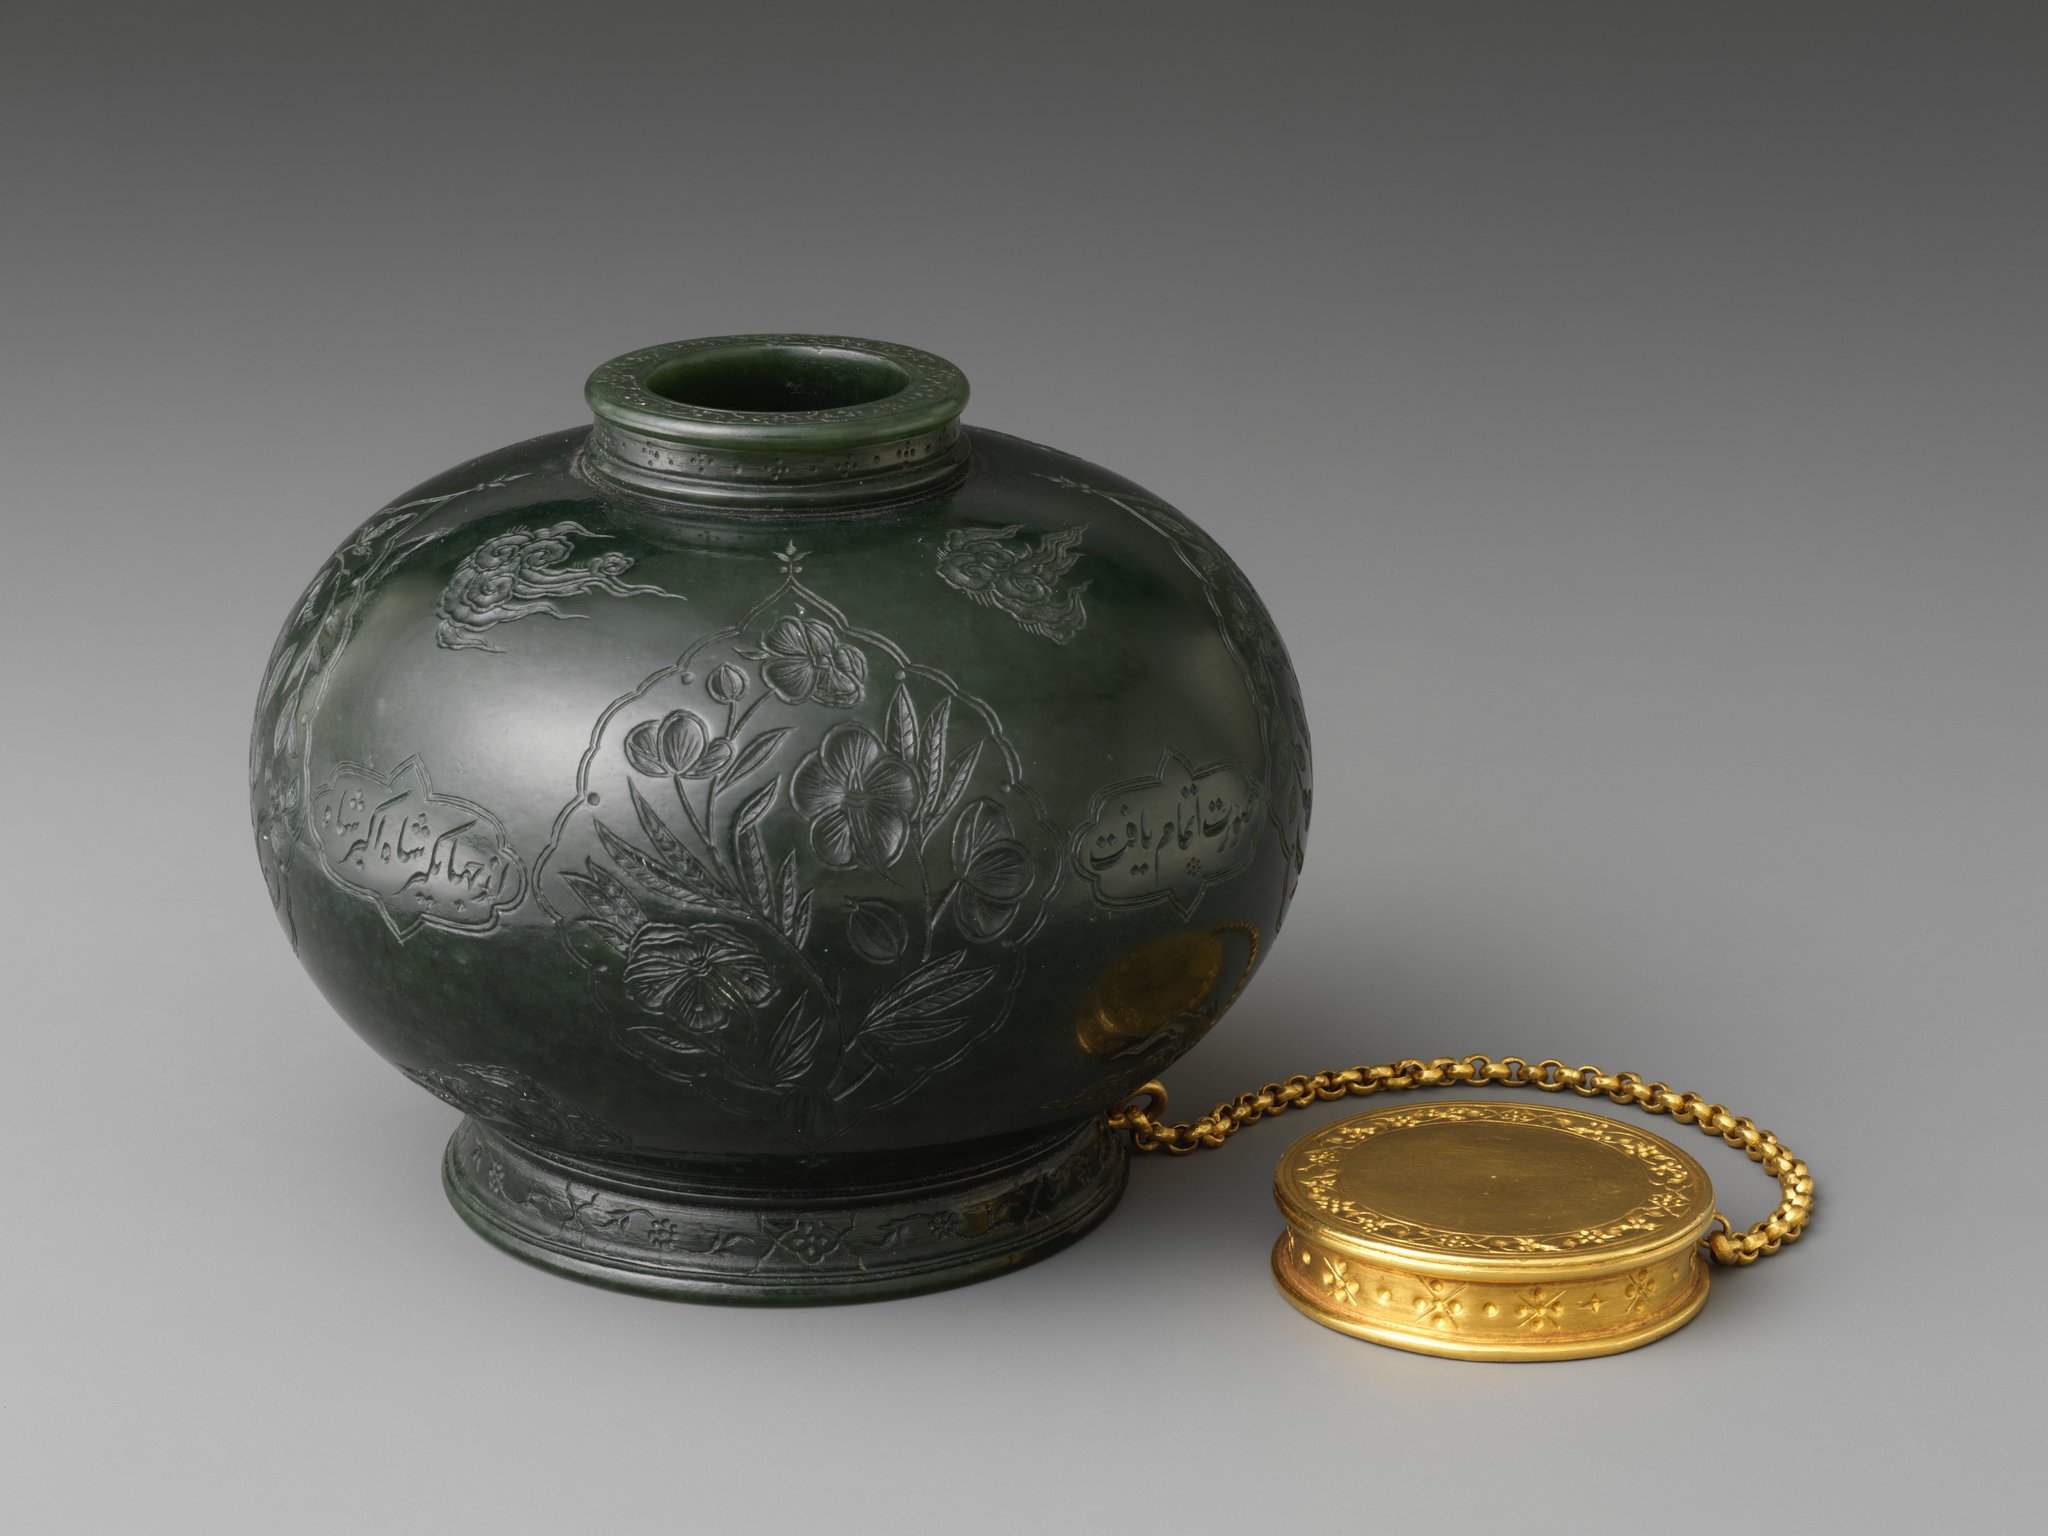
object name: inkwell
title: Inkpot of the Emperor Jahangir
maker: mu'min jahangir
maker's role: maker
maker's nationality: indian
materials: gold, jade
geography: india